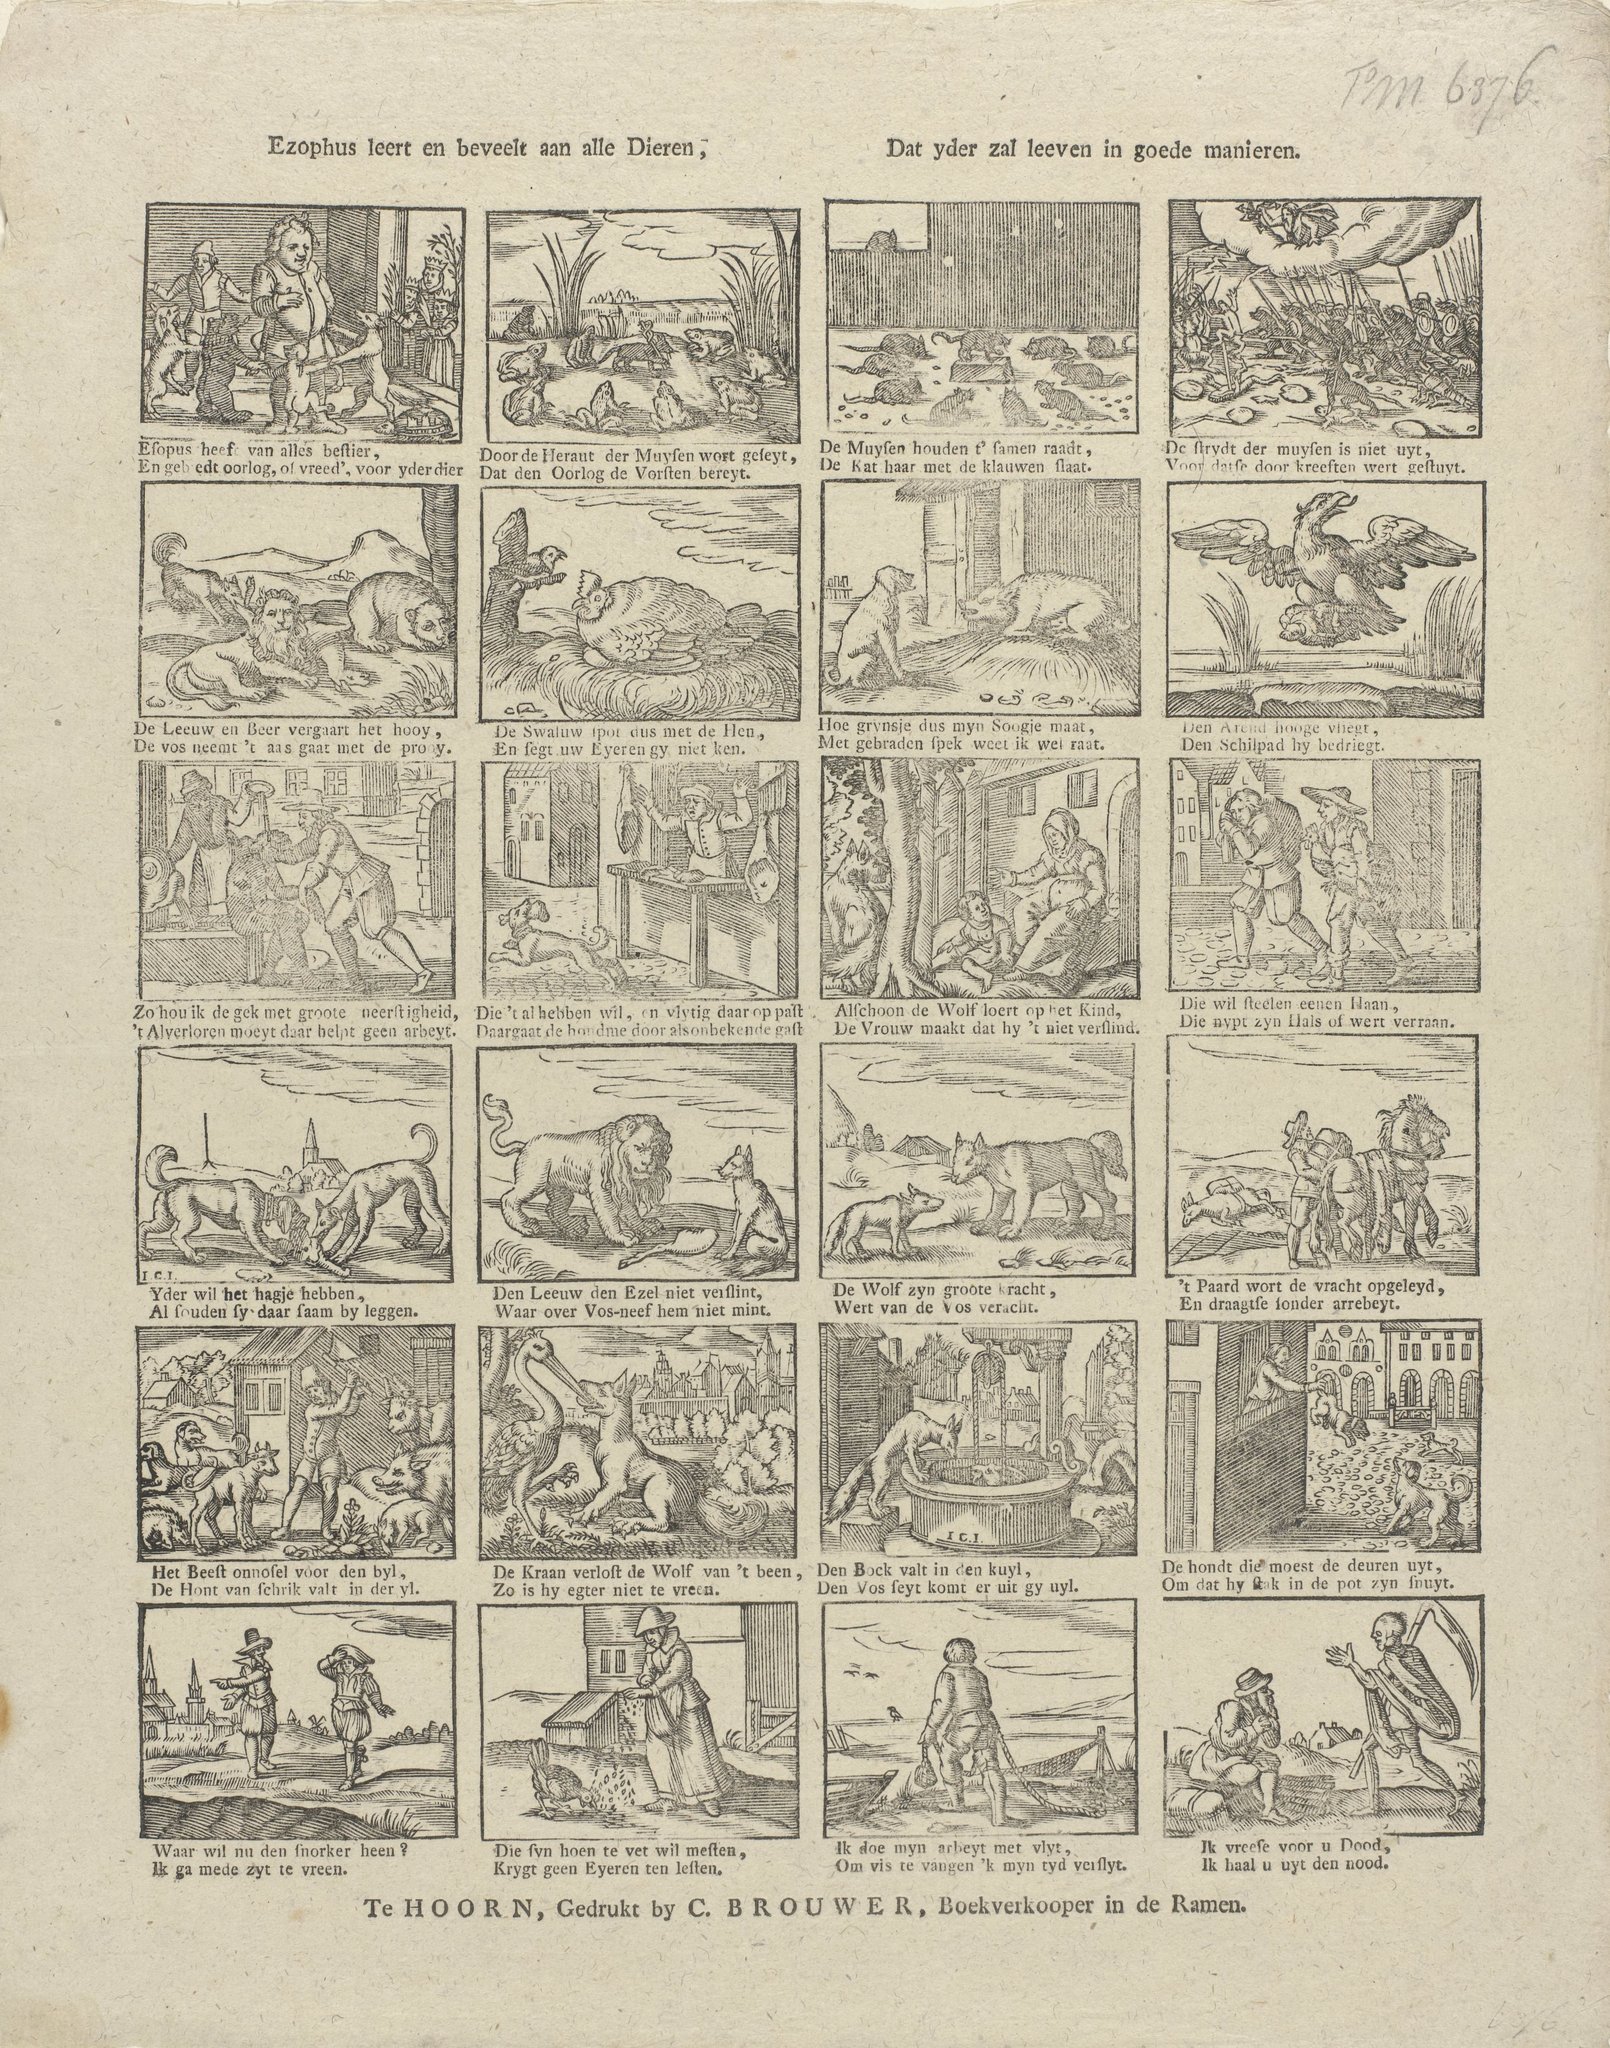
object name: print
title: Ezophus leert en beveelt aan alle dieren, / Dat yder zal leeven in goede manieren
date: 1773-1788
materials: paper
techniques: letterpress printing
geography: hoorn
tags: predatory birds: eagle, fables, beasts of prey, predatory animals: lion, beasts of prey, predatory animals: fox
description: Blad met 24 voorstellingen uit de fabelen van Aesopus, met verschillende dieren die gestraft worden. Onder elke voorstelling een tweeregelig vers.